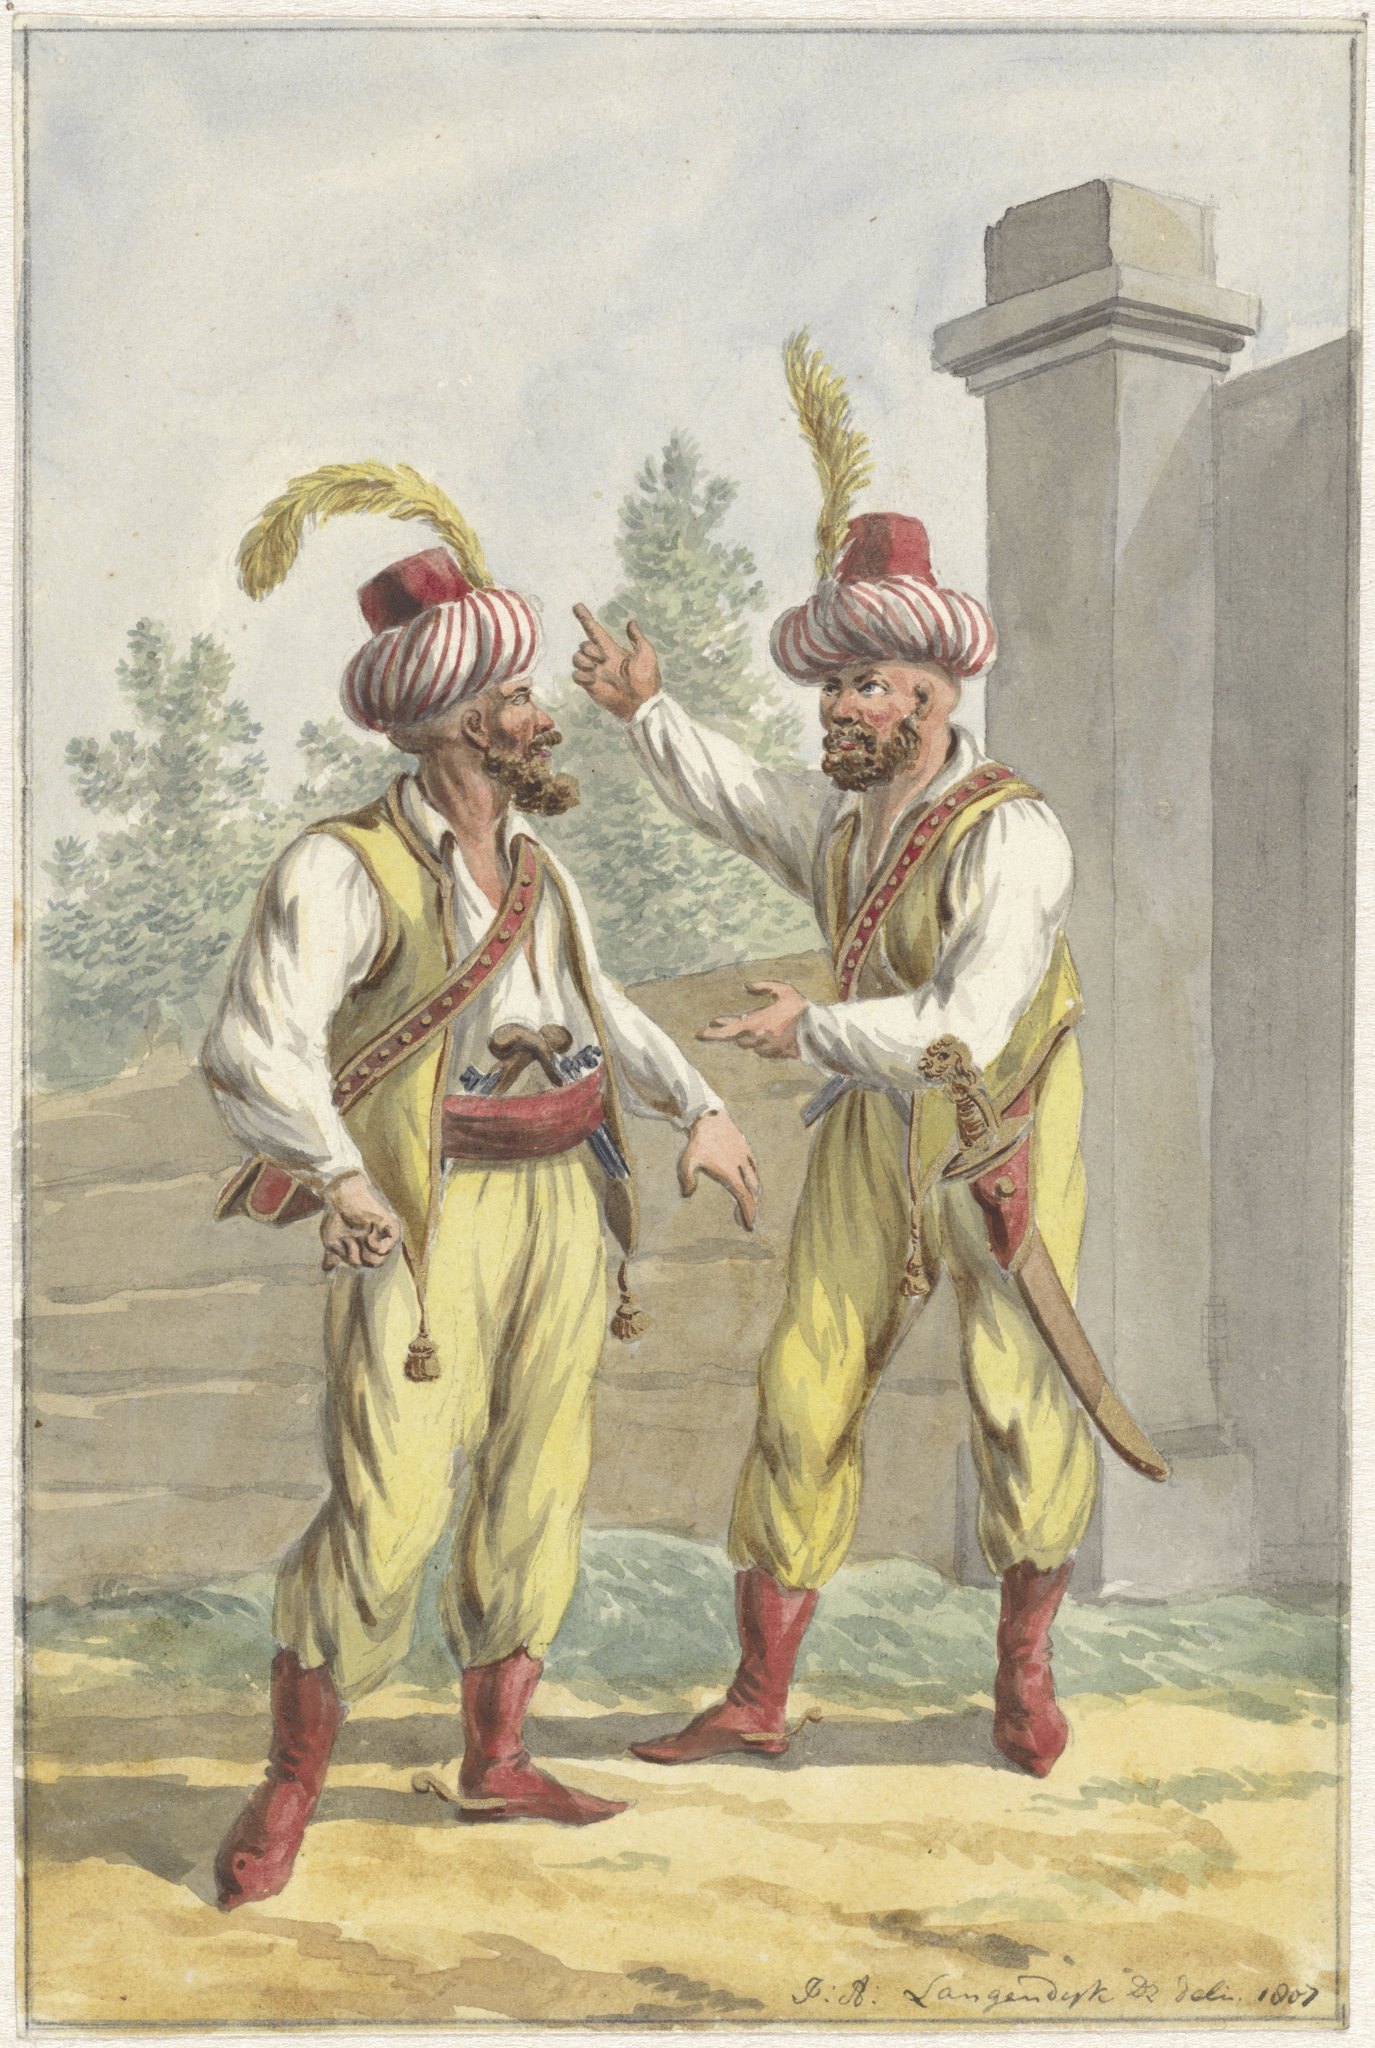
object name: drawing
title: Twee gardisten van Koning Lodewijk Napoleon met tulbanden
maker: jan anthonie langendijk dzn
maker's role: draughtsman, print maker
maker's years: 1780-1818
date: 1807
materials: paint, paper, pencil, watercolor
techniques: brush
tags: (military) uniforms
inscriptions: date